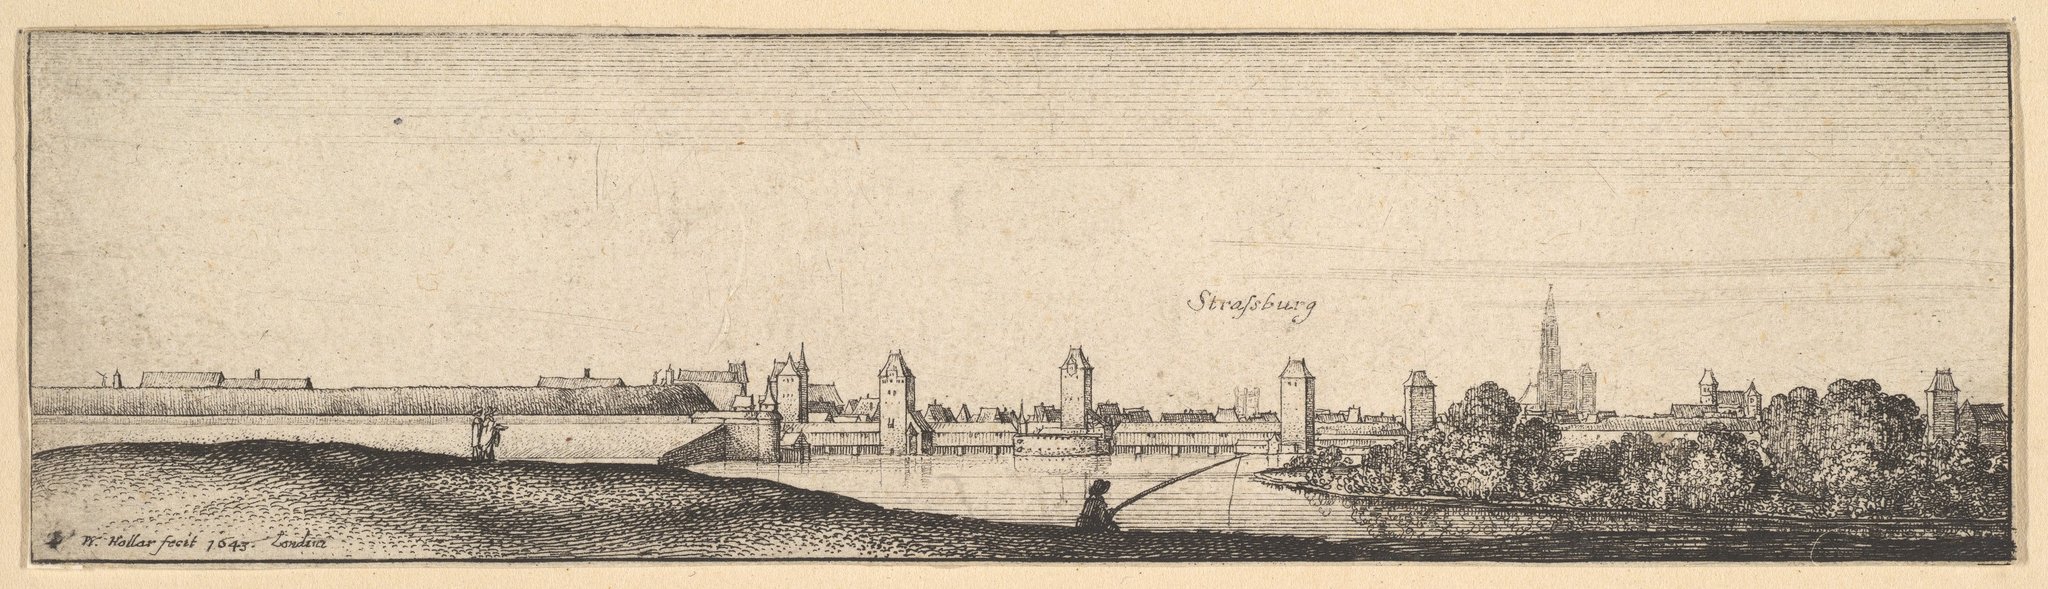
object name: print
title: Strasbourg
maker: wenceslaus hollar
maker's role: artist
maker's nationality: bohemian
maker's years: 1607-1677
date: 1642-1644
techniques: etching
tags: buildings,fishing,rivers